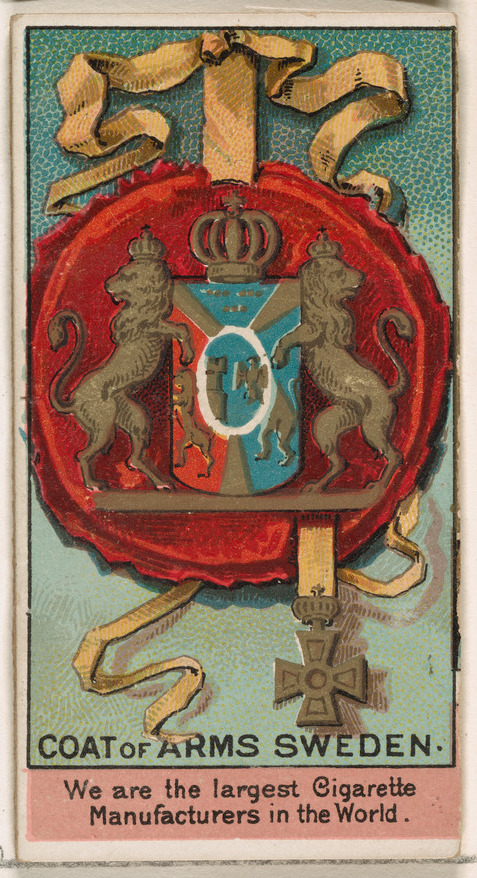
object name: print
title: Oscar II, King of Sweden and Norway, from the Rulers, Flags, and Coats of Arms series (N126-2) issued by W. Duke, Sons & Co.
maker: w. duke, sons & co.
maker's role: publisher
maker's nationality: american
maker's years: 1870-1920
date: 1888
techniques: color lithograph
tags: kings,men,portraits,women,coat of arms